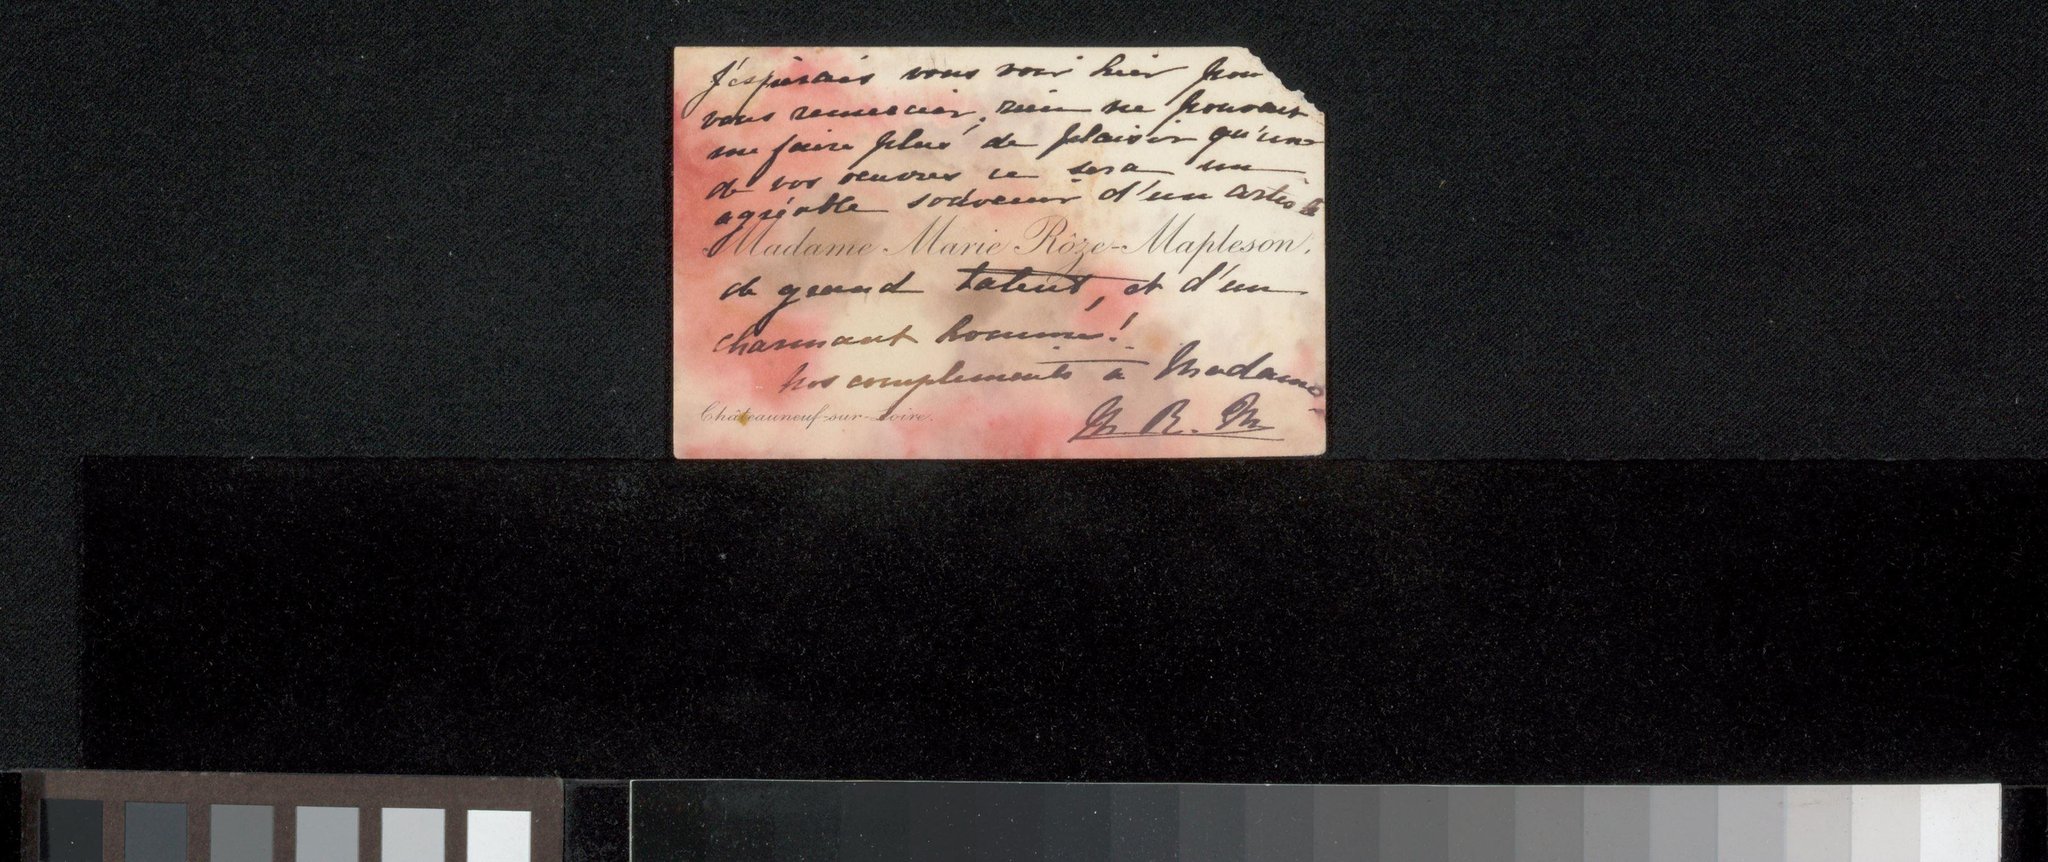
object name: visiting card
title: Visitekaartje aan Philip Zilcken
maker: marie roze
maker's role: zangeres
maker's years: 1846-1926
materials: cardboard, ink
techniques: pen, printing, writing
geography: the hague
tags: the hague, painter, draughtsman, philip zilcken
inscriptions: collector's mark: ‘RPK’